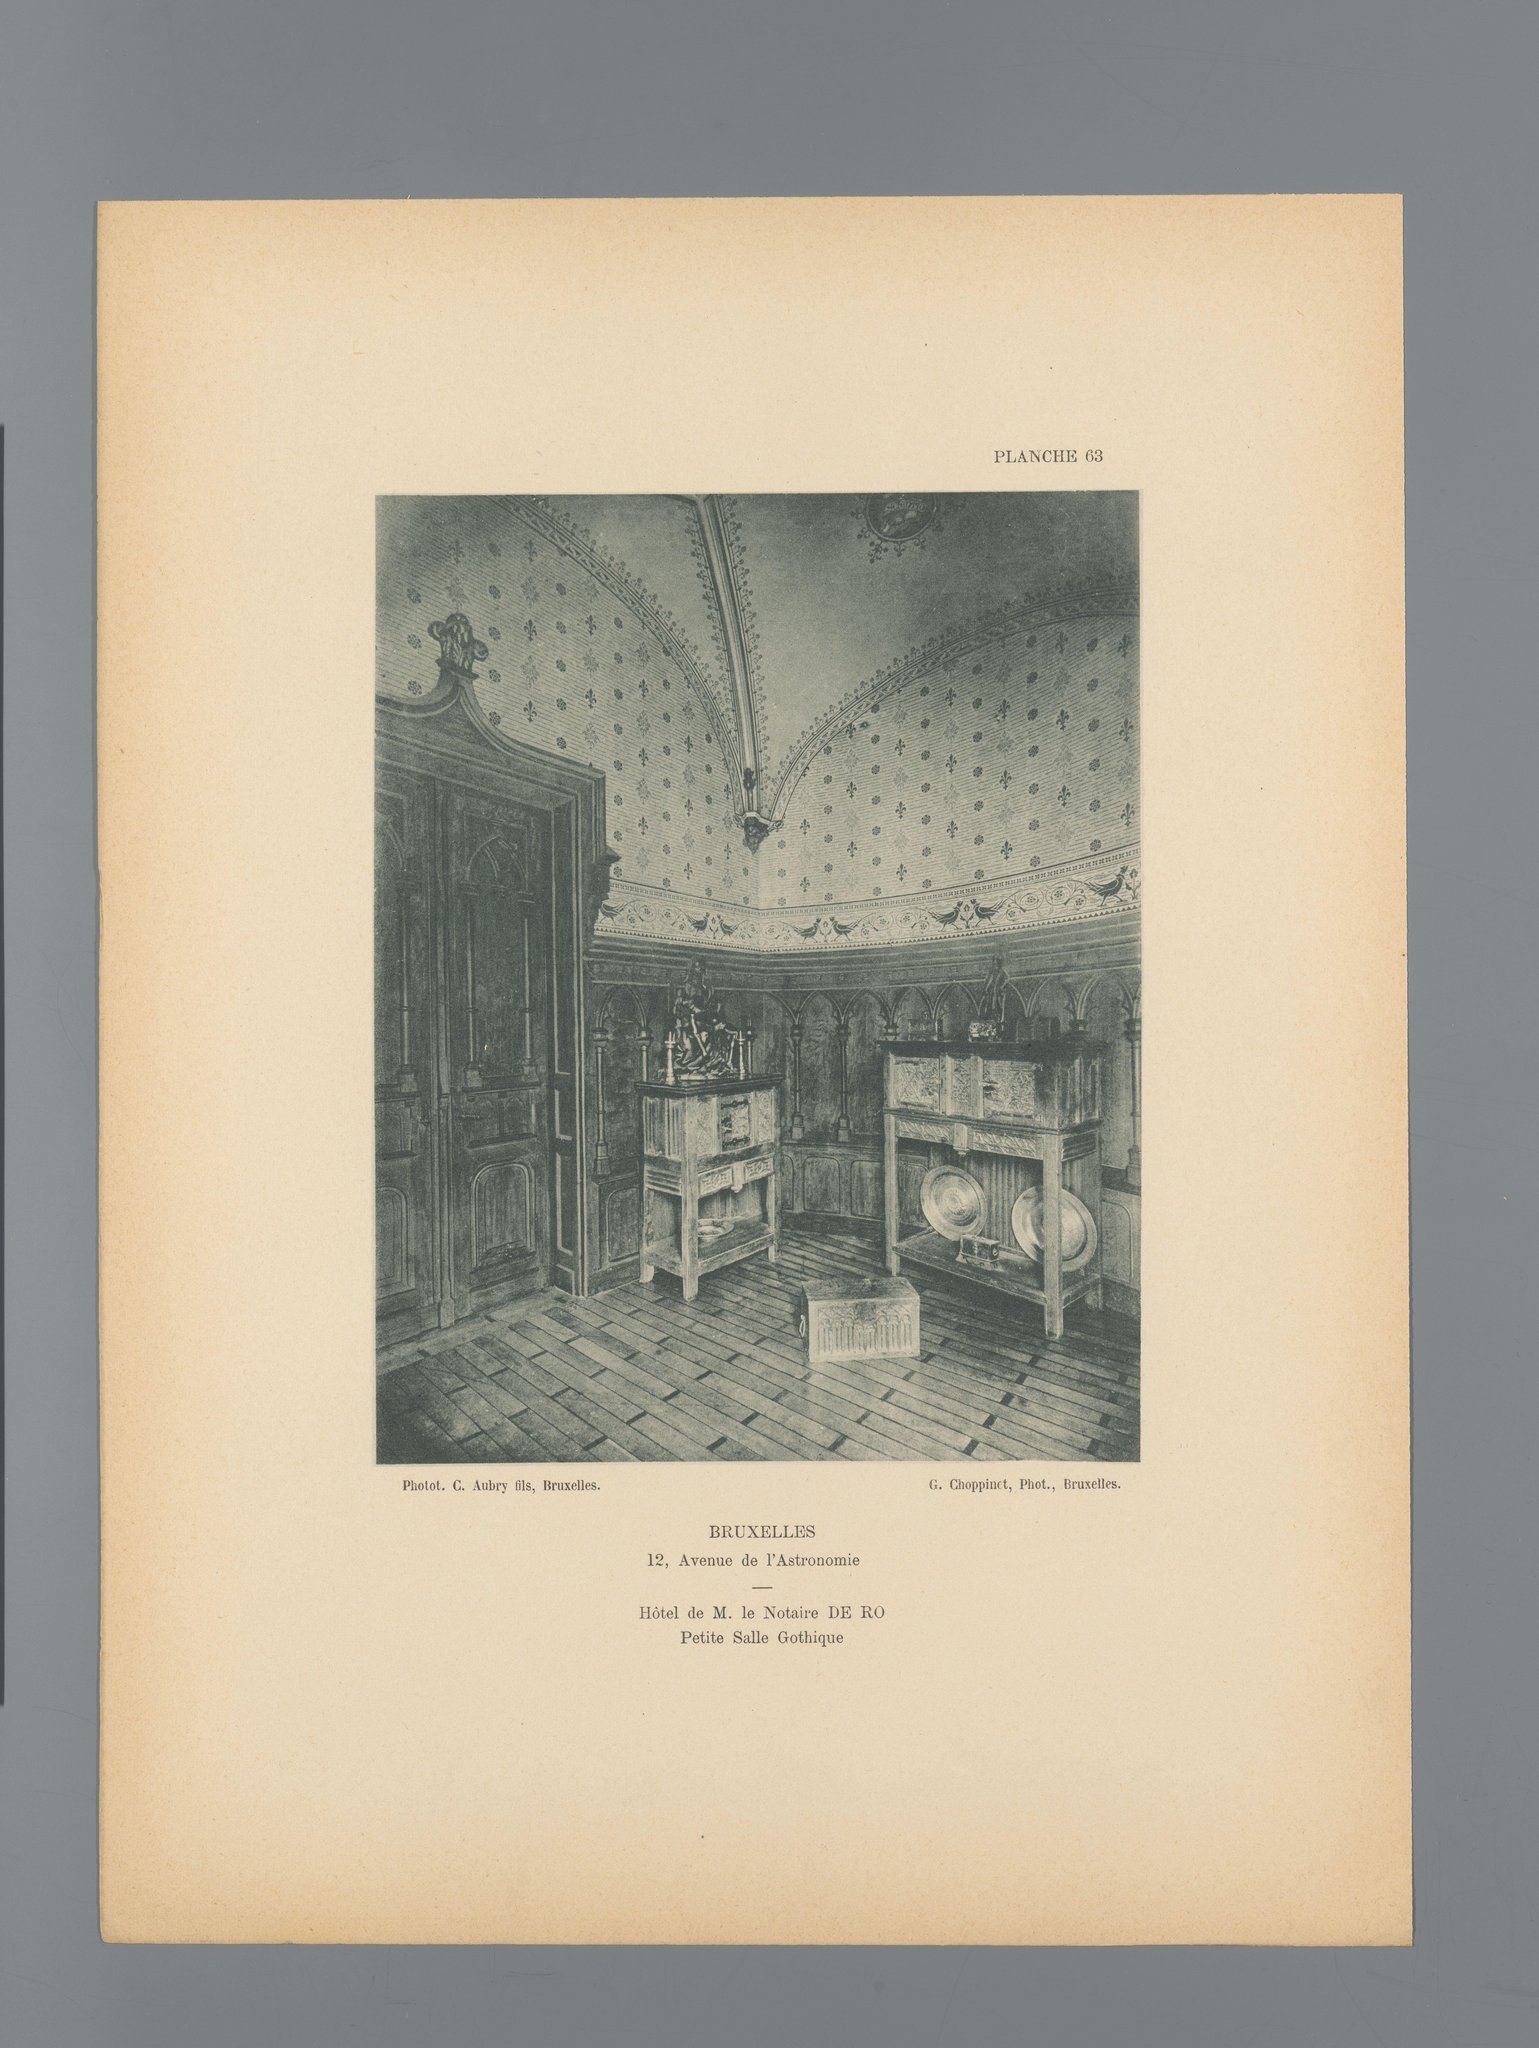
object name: photomechanical print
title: Bruxelles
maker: gustave choppinet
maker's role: fotograaf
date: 1893-1898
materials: paper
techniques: photograph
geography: brussels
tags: interior of the house, hotel, hostelry, inn, brussels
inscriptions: inscription: ‘12, Avenue de l'Astronomie/ Hôtel de M. le Notaire DE RO/ Petite Salle Gothique’, number: ‘PLANCHE 63’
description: Deze prent maakt deel uit van een omslag met 89 prenten en 5 tekstbladen.